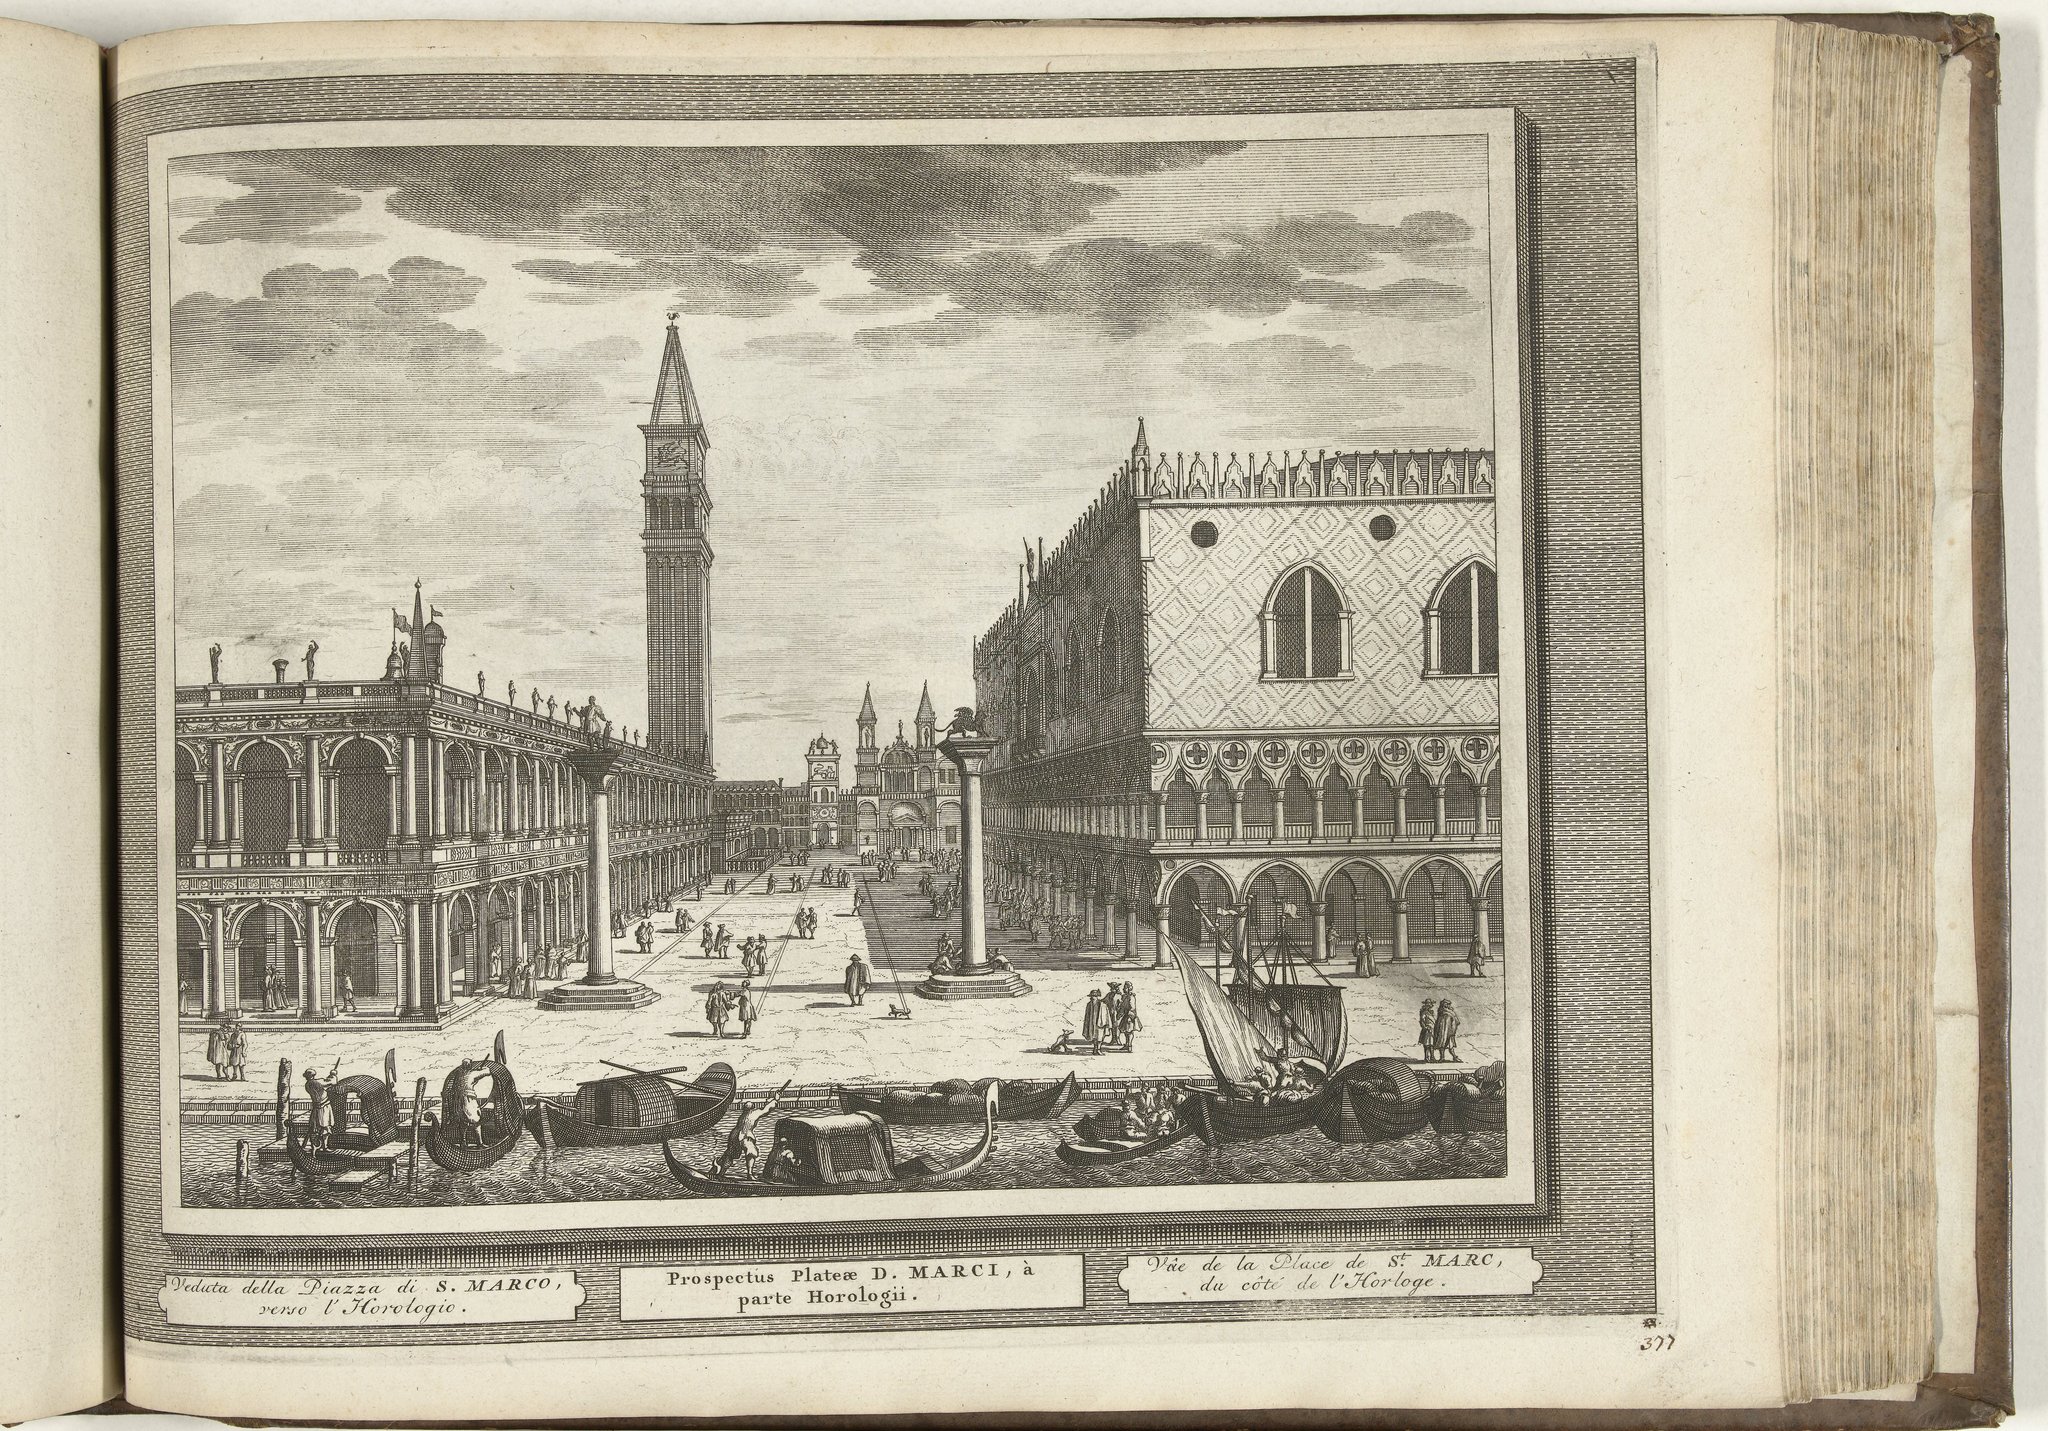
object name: print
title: Les Forces de l'Europe, Asie, Afrique et Amerique (...) Comme aussi les Cartes des Côtes de France et d'Espagne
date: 1726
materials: paper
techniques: etching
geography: northern netherlands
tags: san marcoplein, spaanse successieoorlog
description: Gezicht op de Piazza San Marco te Venetië. Plaat nr. 377 in deel XVI van het prentwerk: Les Forces de l'Europe, Asie, Afrique et Amerique ... Comme aussi les Cartes des Côtes de France et d'Espagne uit 1726, dit tweede deel met 271 met de hand genummerde platen van vermaarde sterke steden en vestingen in het kader van de Spaanse Successieoorlog 1701-1713. Voor het merendeel zijn deze platen gekopieerd naar de anonieme Franse platen van vermaarde sterke steden en vestingen: in Les forces de l'Europe en in: Le theatre de la guerre, dans les Pays-Bas, beide oorspronkelijk uitgegeven door Nicolas de Fer te Parijs (1693-1697) in het kader van de Negenjarige Oorlog. Rechtsonder is het nummer 49 met de pen doorgekrast.